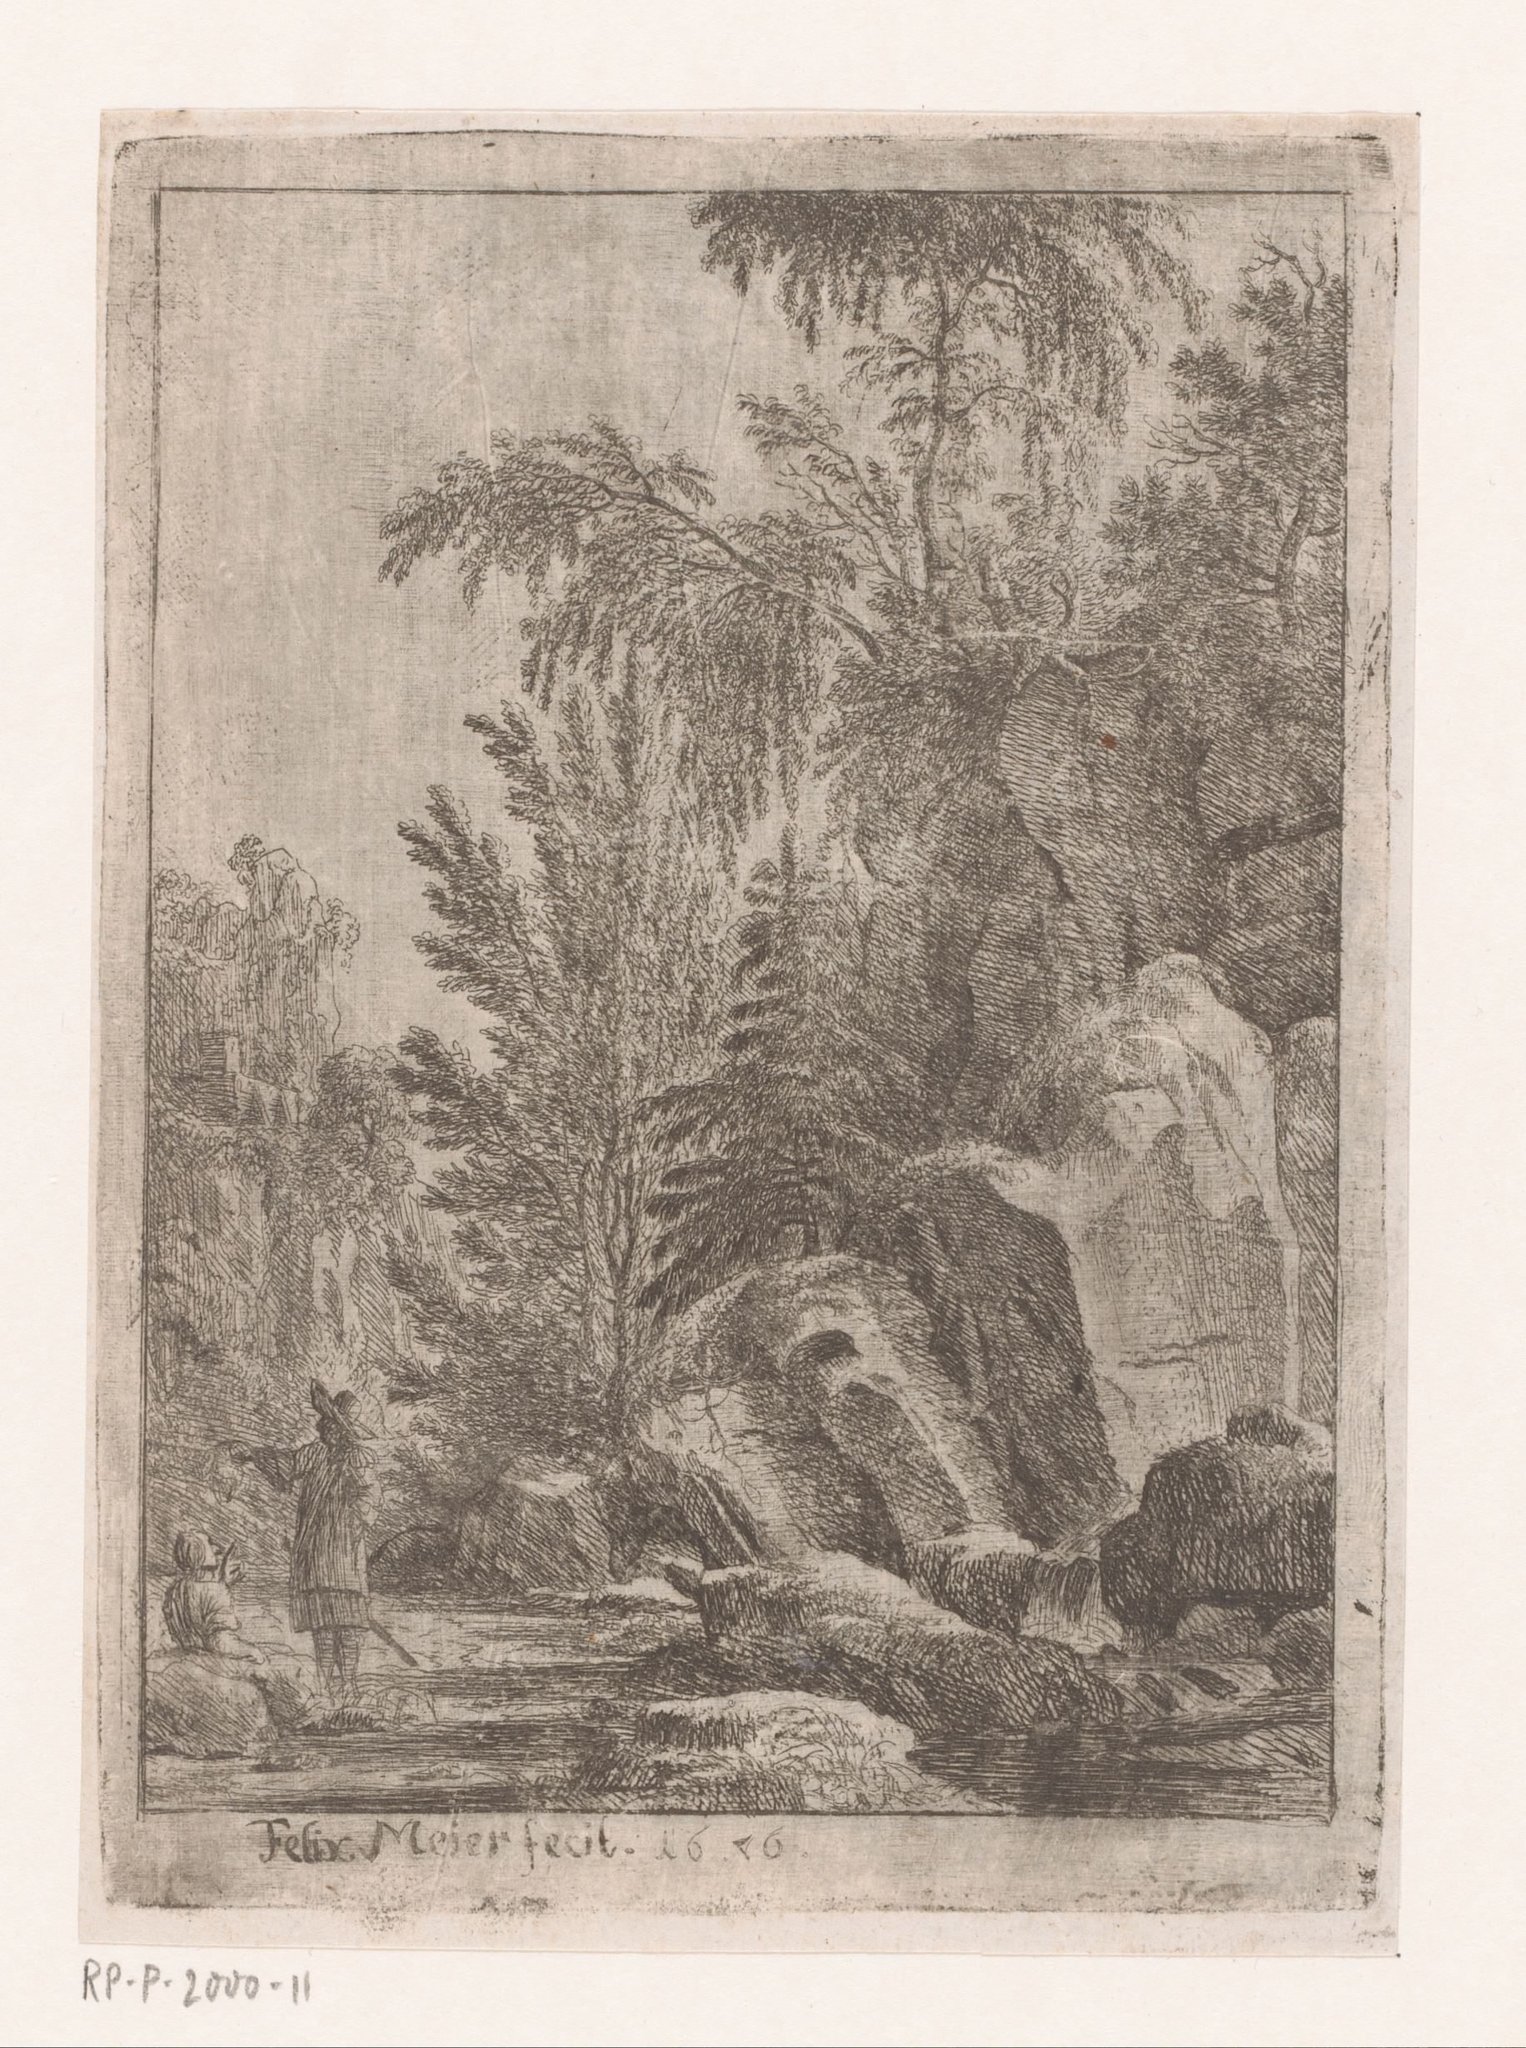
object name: print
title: Rivierlandschap met rots en twee figuren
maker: felix meyer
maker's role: print maker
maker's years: 1653-1713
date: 1676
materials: paper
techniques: etching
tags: landscapes with waters, waterscapes, seascapes (in the temperate zone)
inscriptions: date